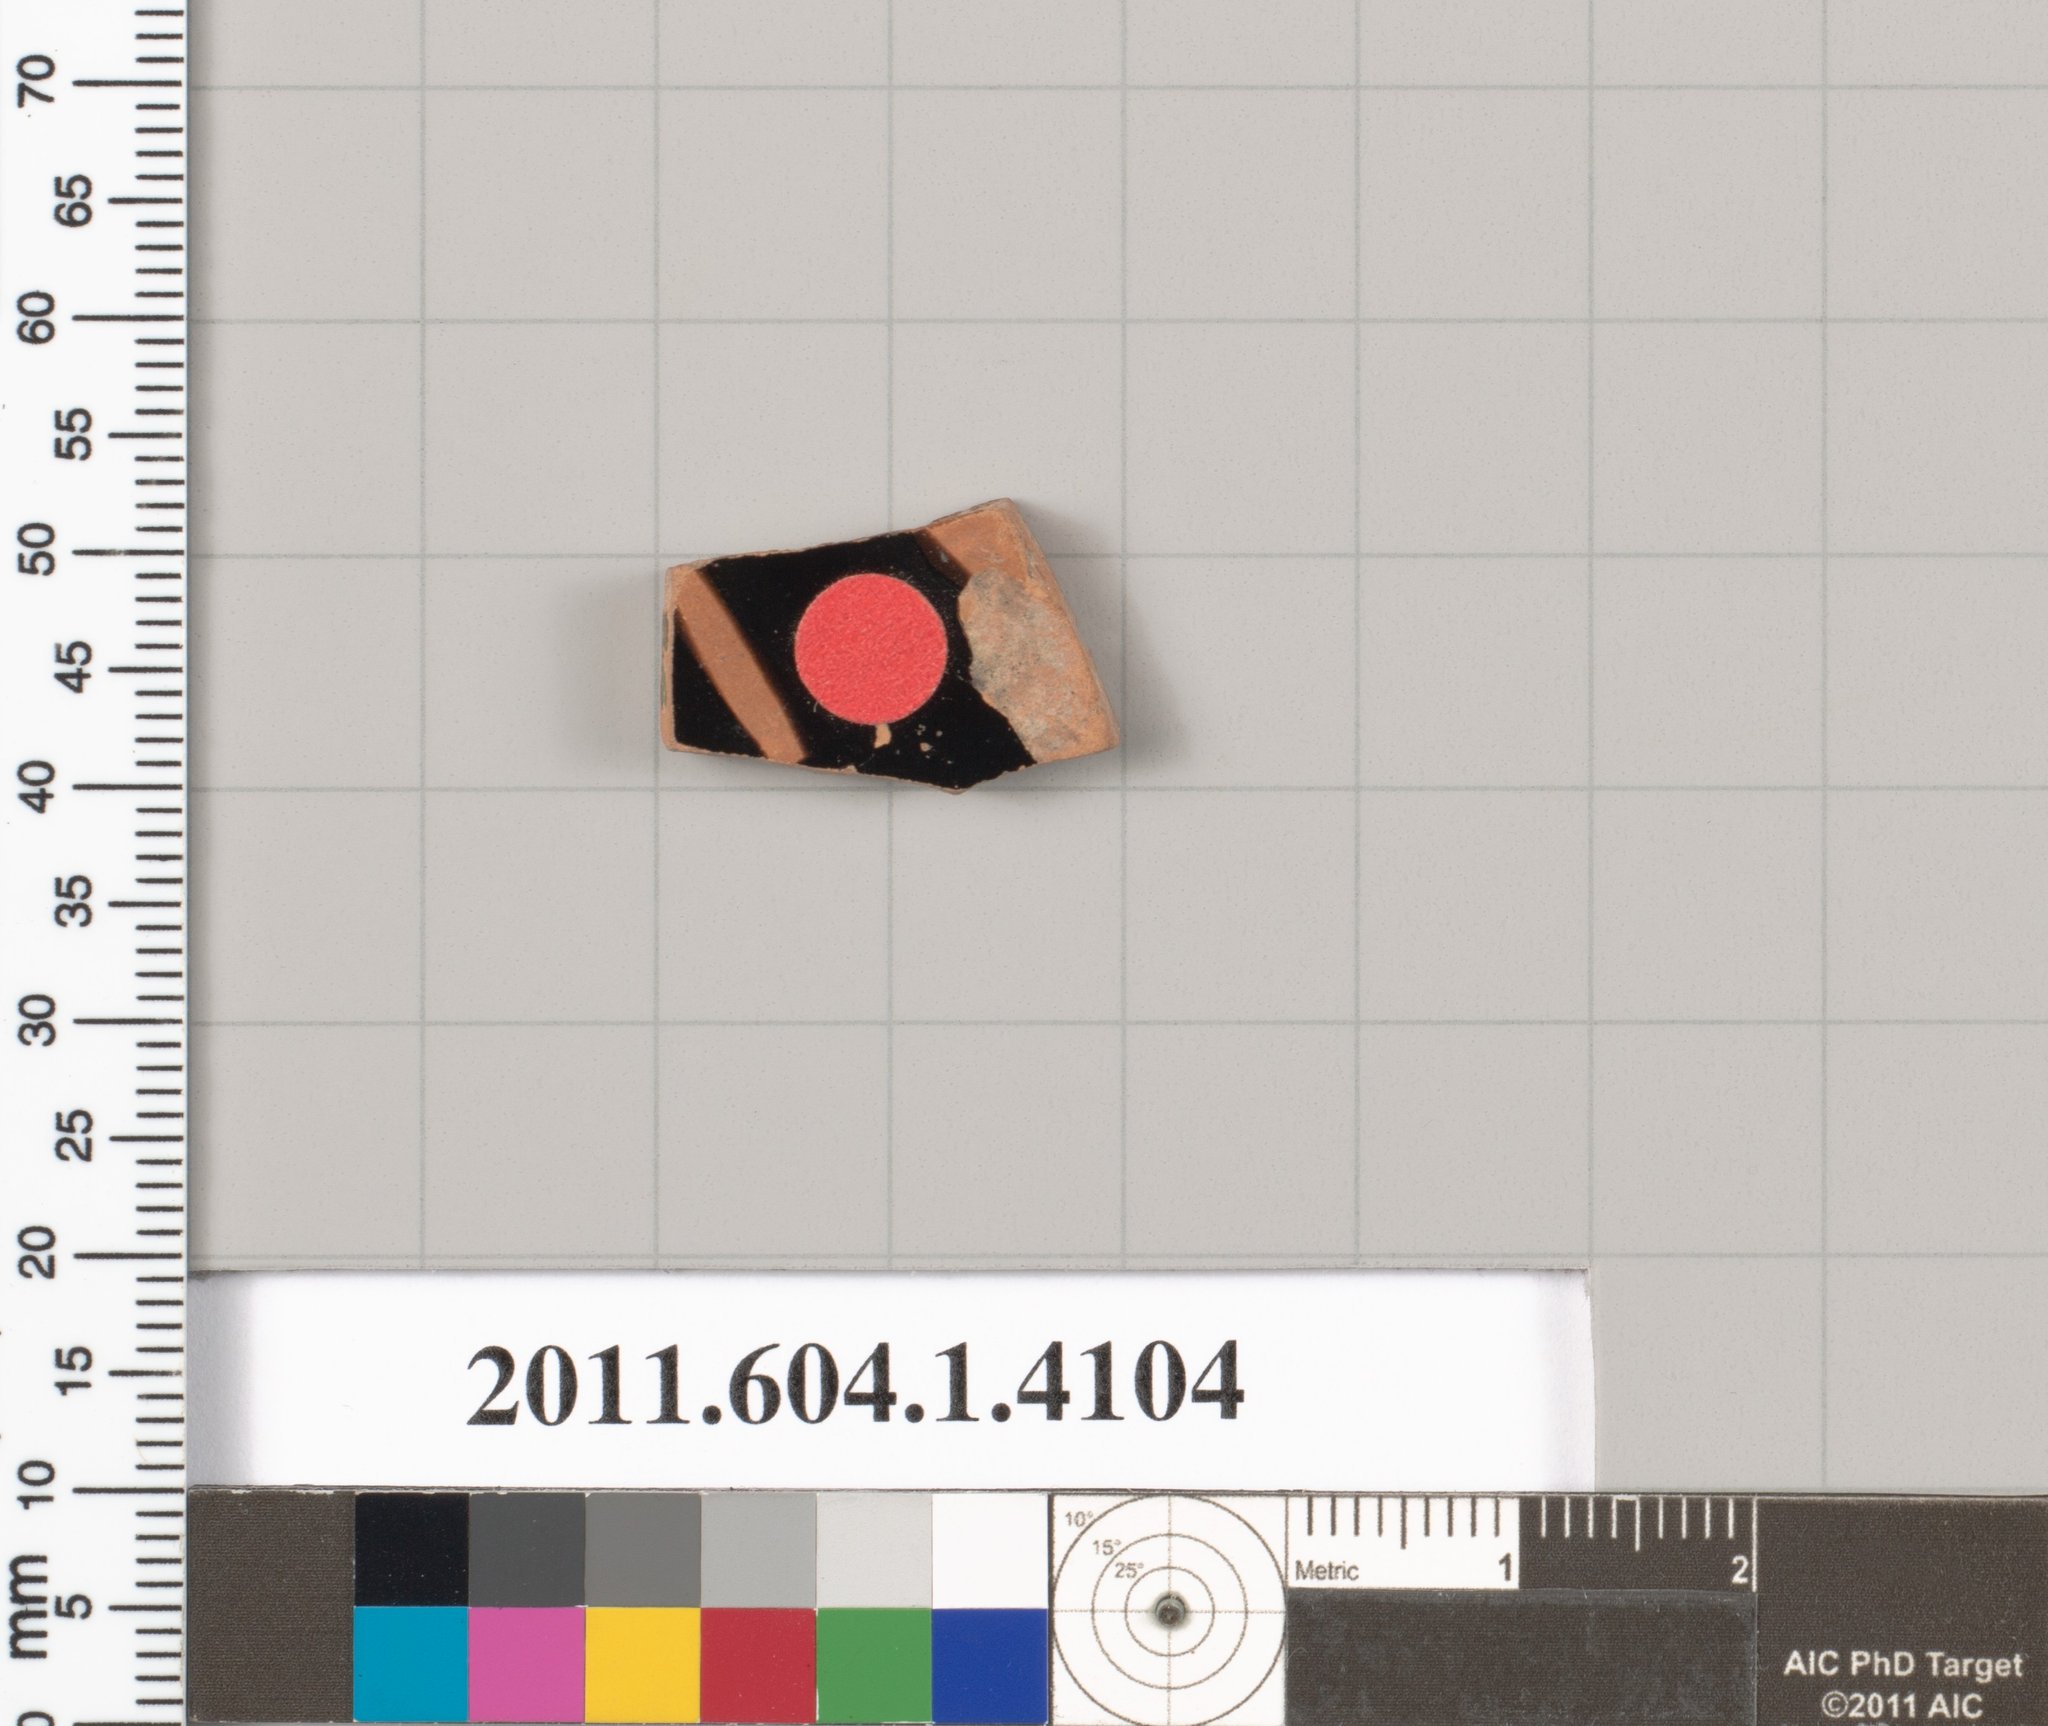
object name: kylix fragment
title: Terracotta fragment of a kylix (drinking cup)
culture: greek, attic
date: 500-480 BCE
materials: terracotta